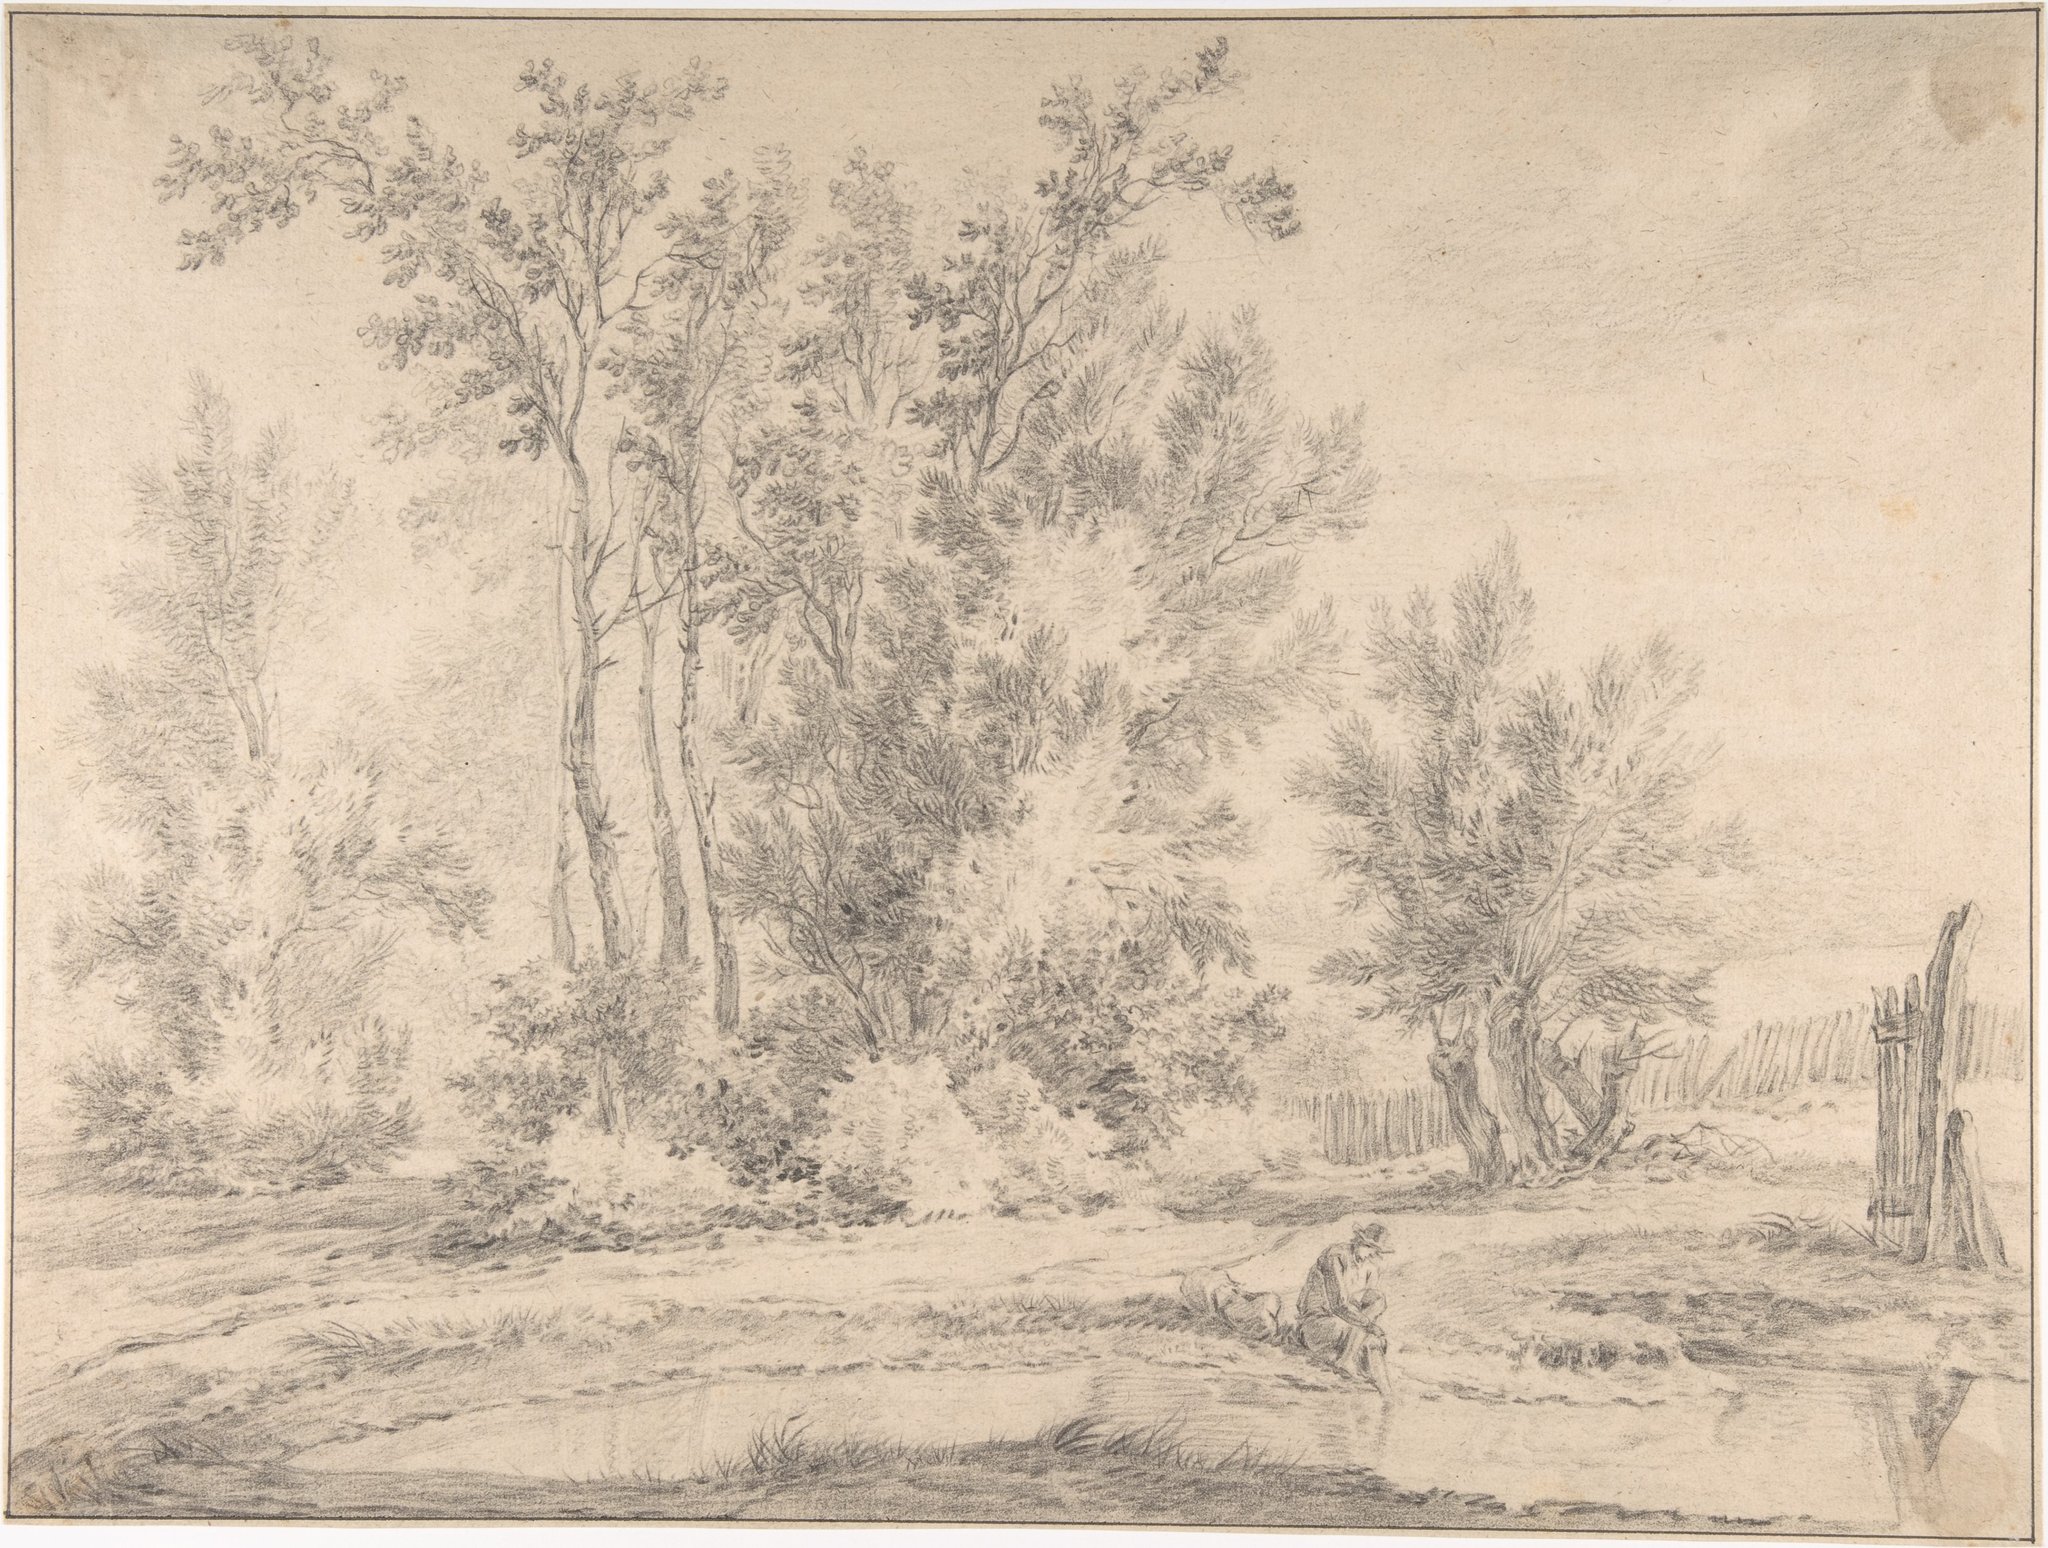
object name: drawing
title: Landscape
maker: anonymous, dutch, 18th century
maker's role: artist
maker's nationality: dutch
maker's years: 1700-1800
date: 1701-1800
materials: chalk, ink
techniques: pen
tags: men,landscapes,trees